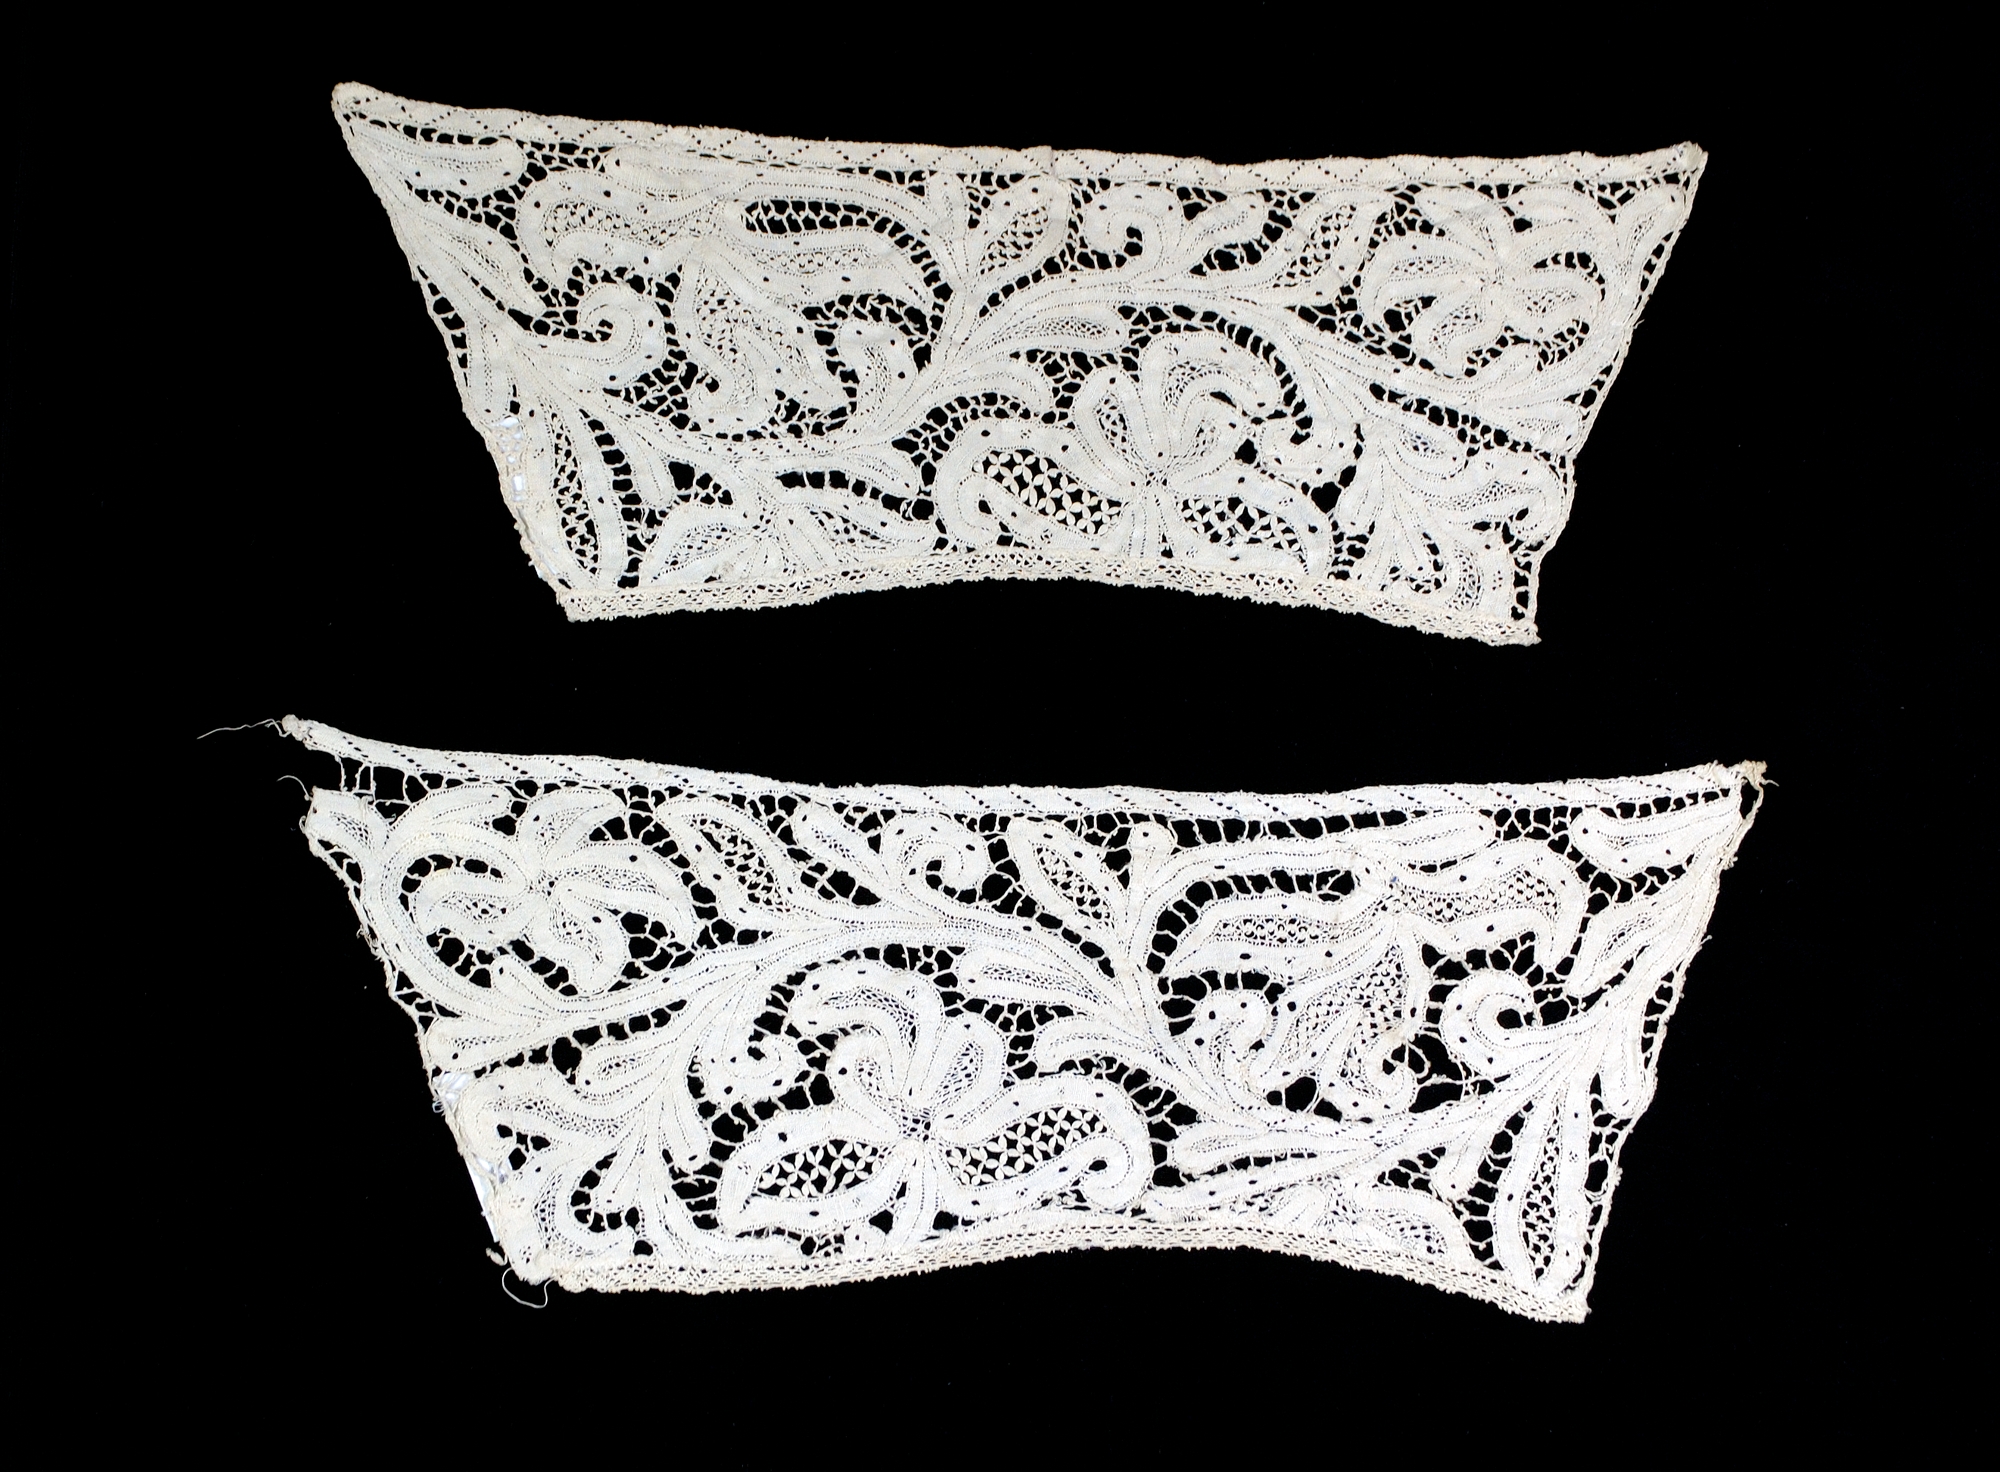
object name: cuff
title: Cuffs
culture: italian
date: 1676-1700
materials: linen